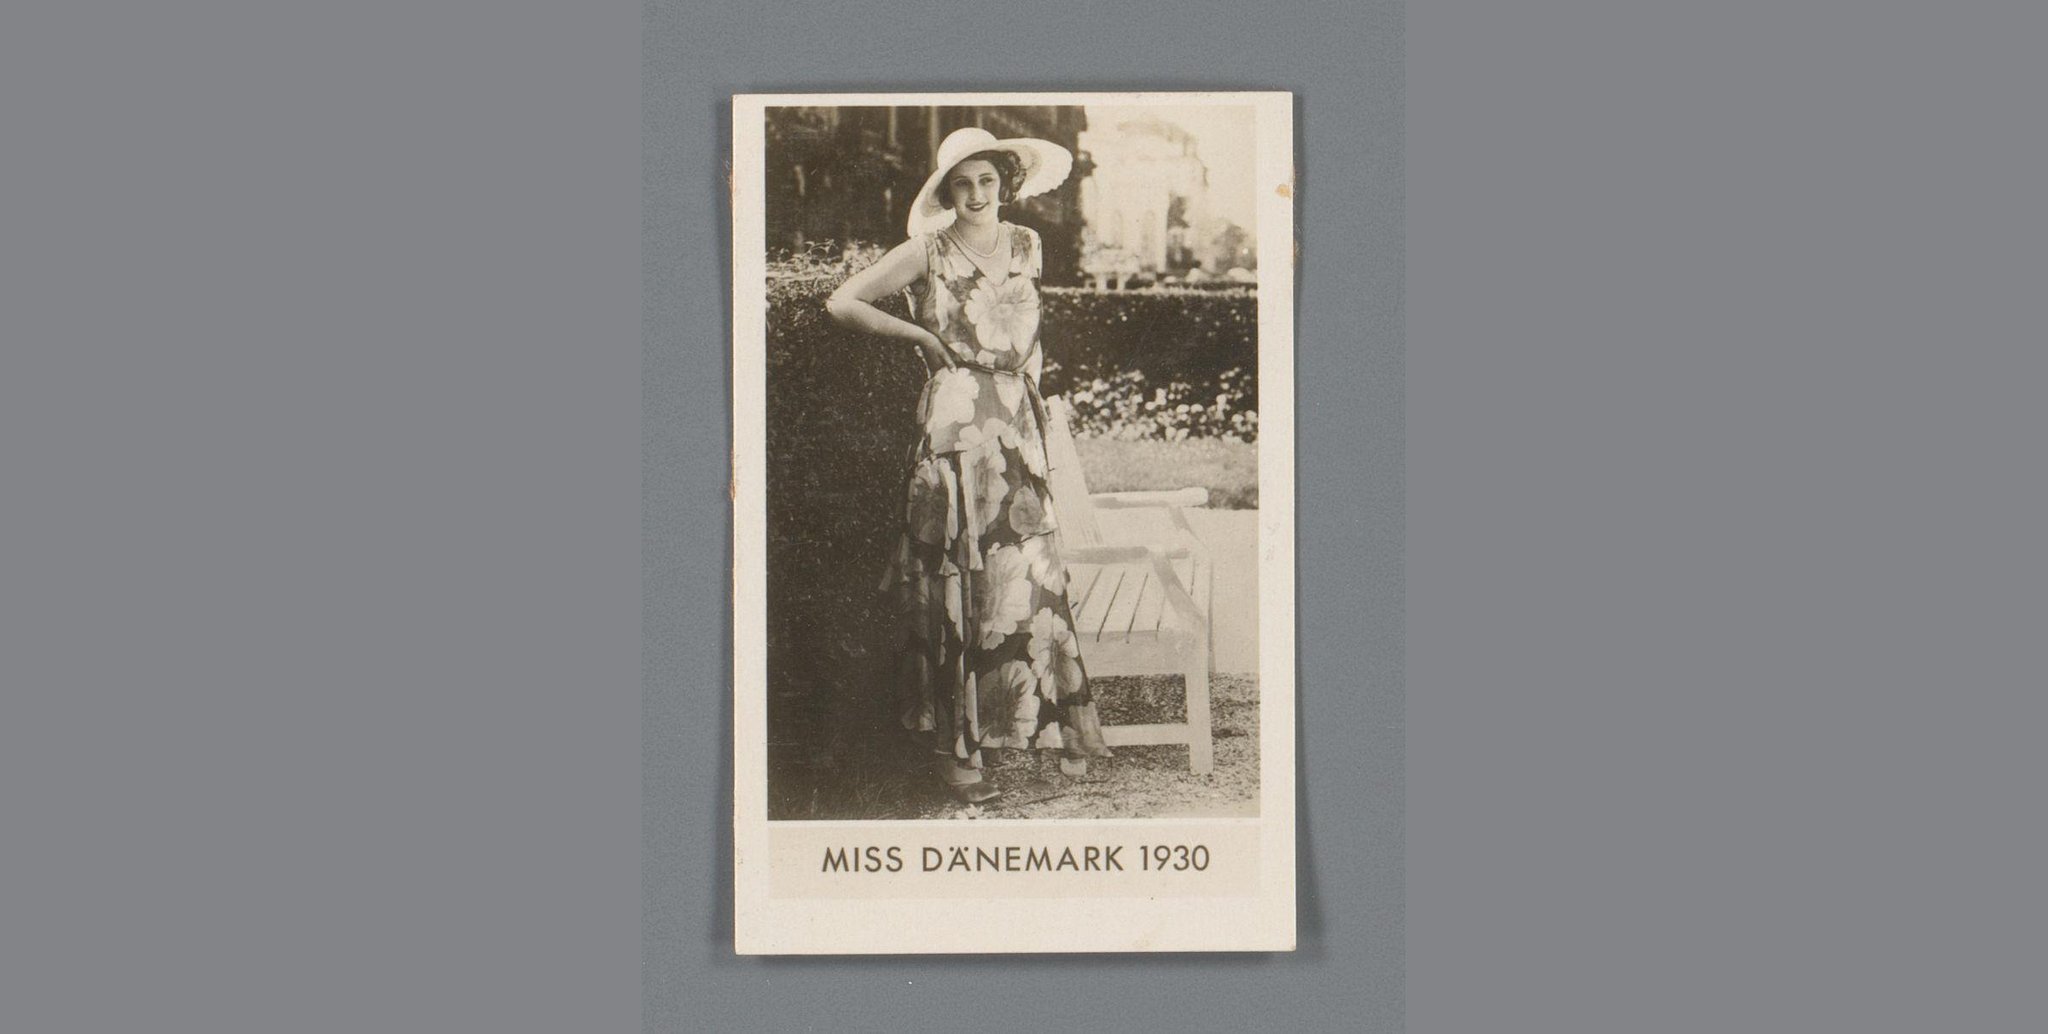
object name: photograph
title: Miss Dänemark 1930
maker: Anonymous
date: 1930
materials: paper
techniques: gelatin silver print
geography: dresden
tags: historical persons - bb - woman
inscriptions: inscription: ‘Die schönsten/ Frauen der Welt/ dargestellt durch die Schön-/ heitsköniginnen aller Länder,/ finden Sie in 190 echten/ Bromsilber-Fotos, die nur den/ CLUB-und-LIGA-Packun-/ gen beiliegen. Eind prächtiges/ Sammel-Album erhalten Sie/ für 75 Pfennig vom Händler/ oder bei Einsendung von/ 75 Pfennig in Briefmarken/ von der Bilderstelle Lohse,/ Dresden A24, Nossener Str. 1./ Ges. gesch. Nachdruck verboten!’